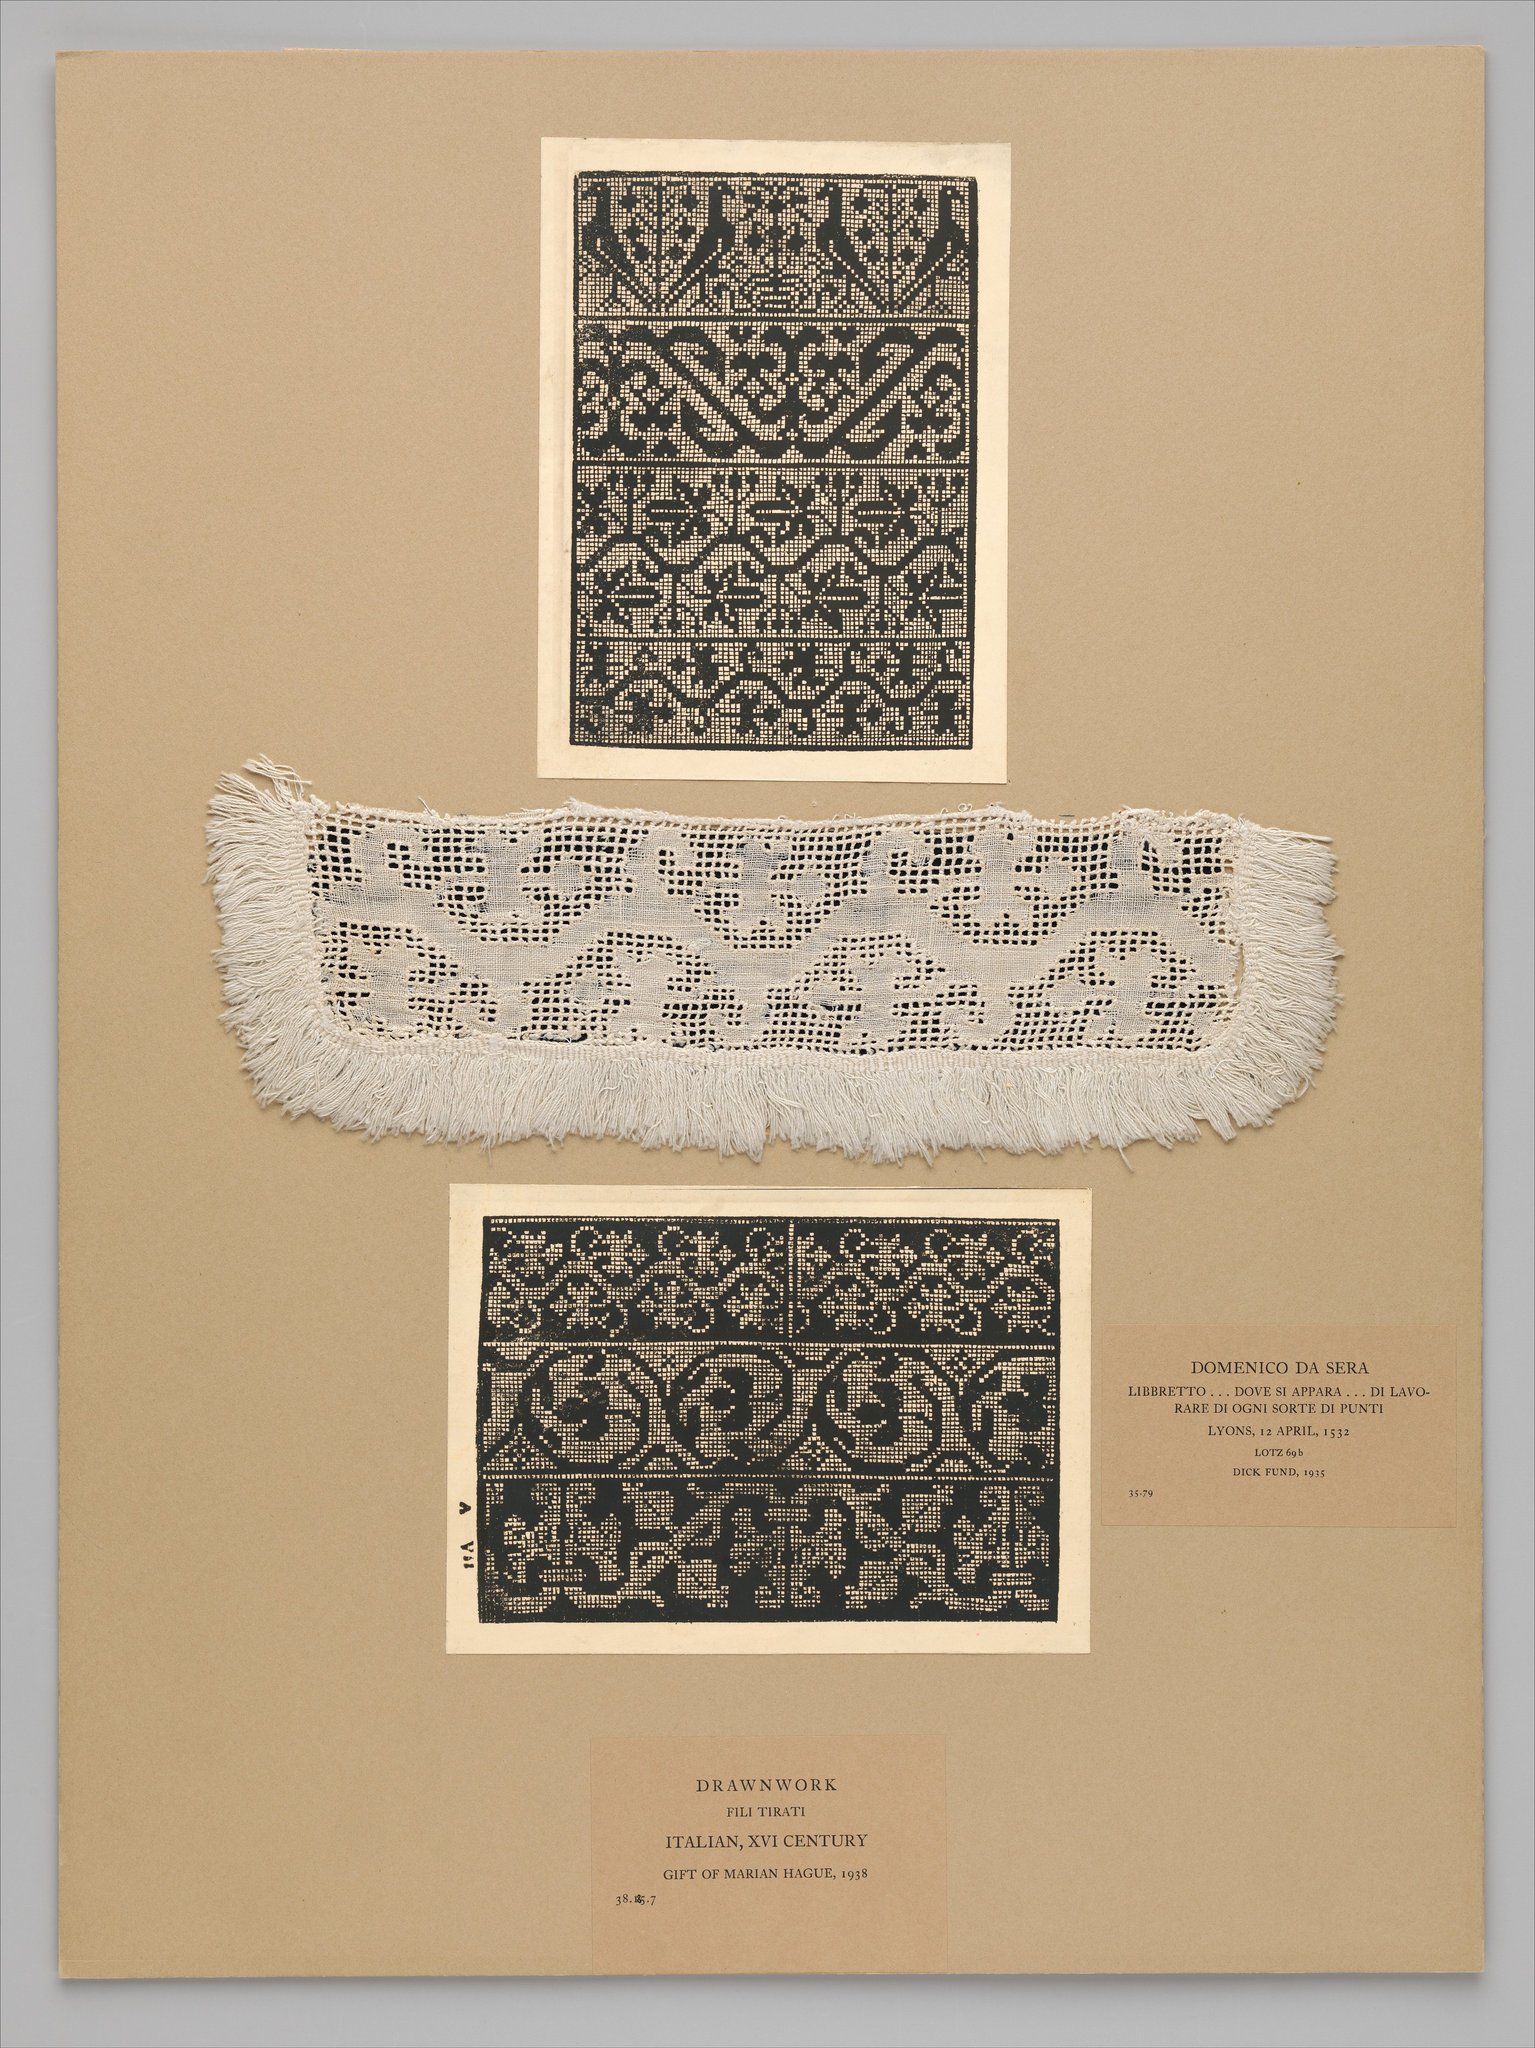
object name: piece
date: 1501-1600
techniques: embroidery